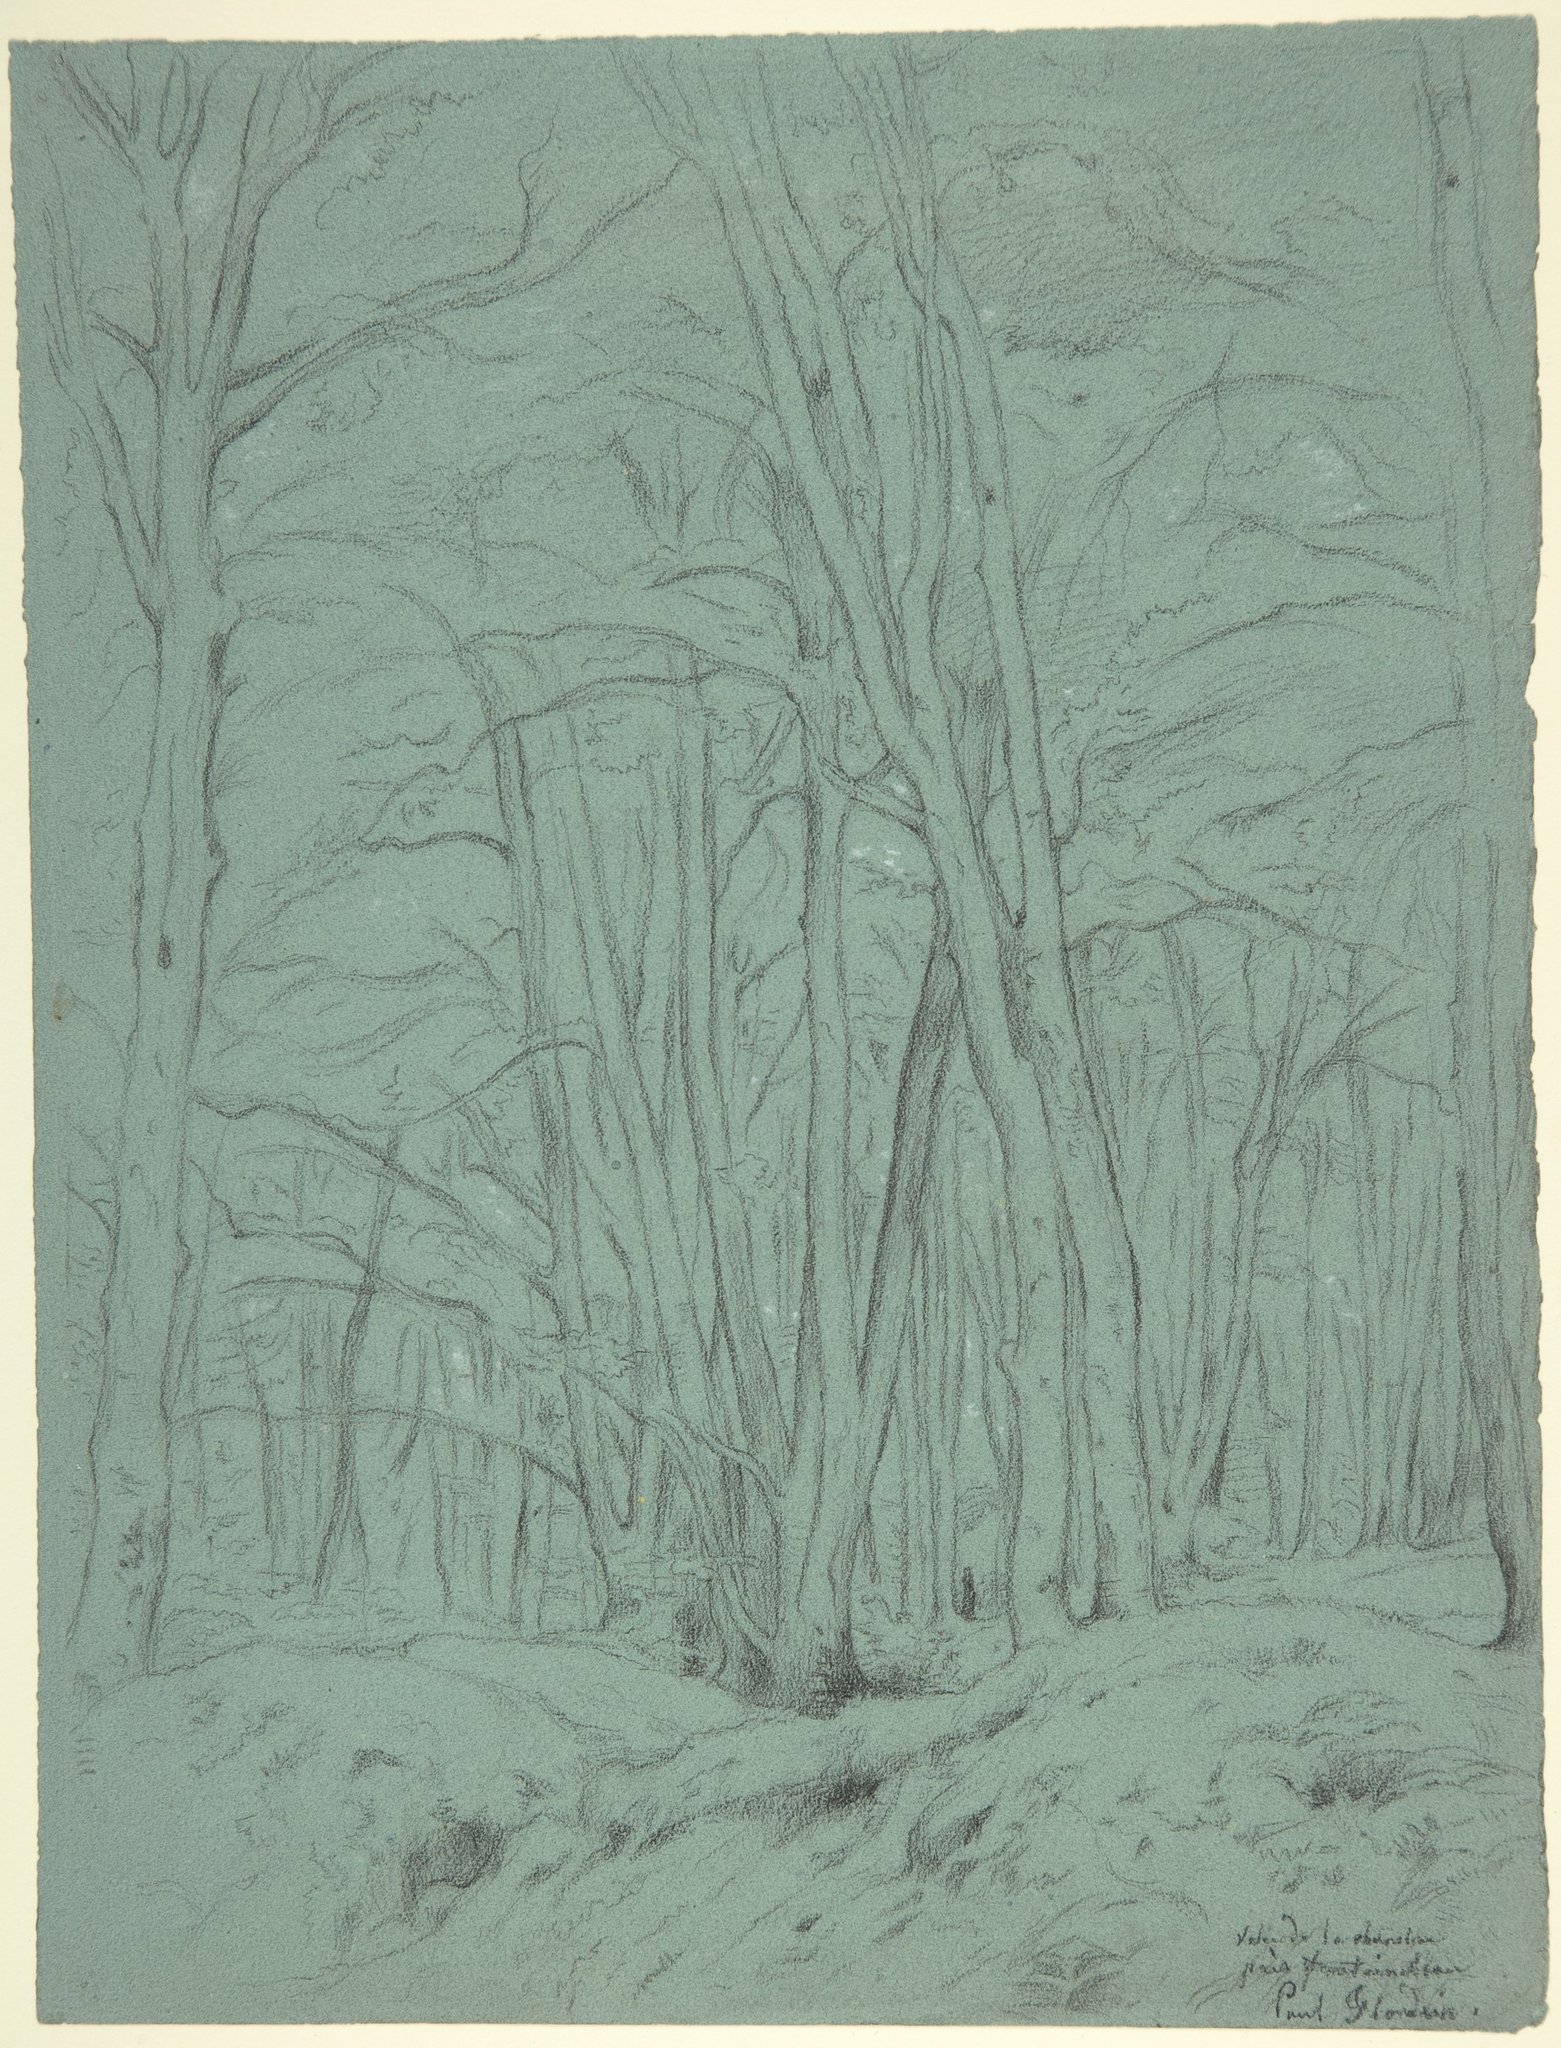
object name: drawing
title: Forest View Near Fontainebleau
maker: paul flandrin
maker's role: artist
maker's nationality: french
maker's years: 1811-1902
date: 1801-1900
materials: chalk, paper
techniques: heightening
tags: forests,trees